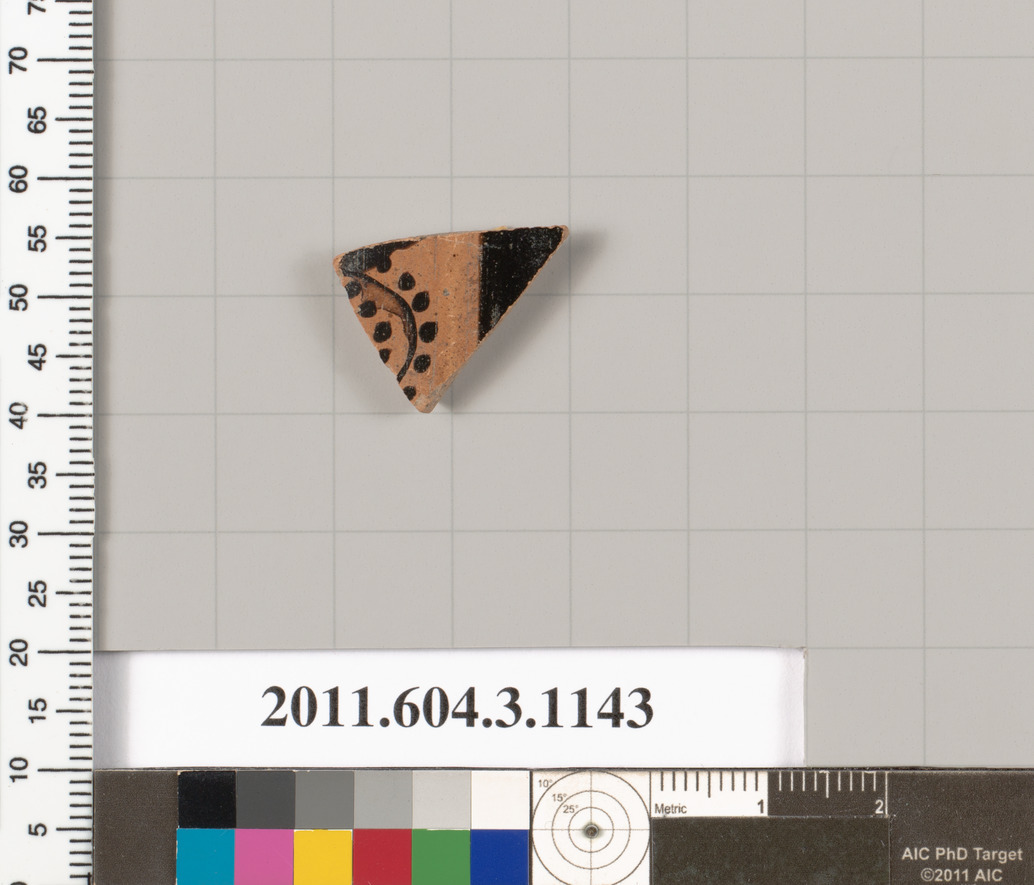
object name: mastoid or kyathos fragment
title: Terracotta fragment of a mastoid (drinking cup with narrow base) or a kyathos (cup-shaped ladle)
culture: greek, attic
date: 534-468 BCE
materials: terracotta